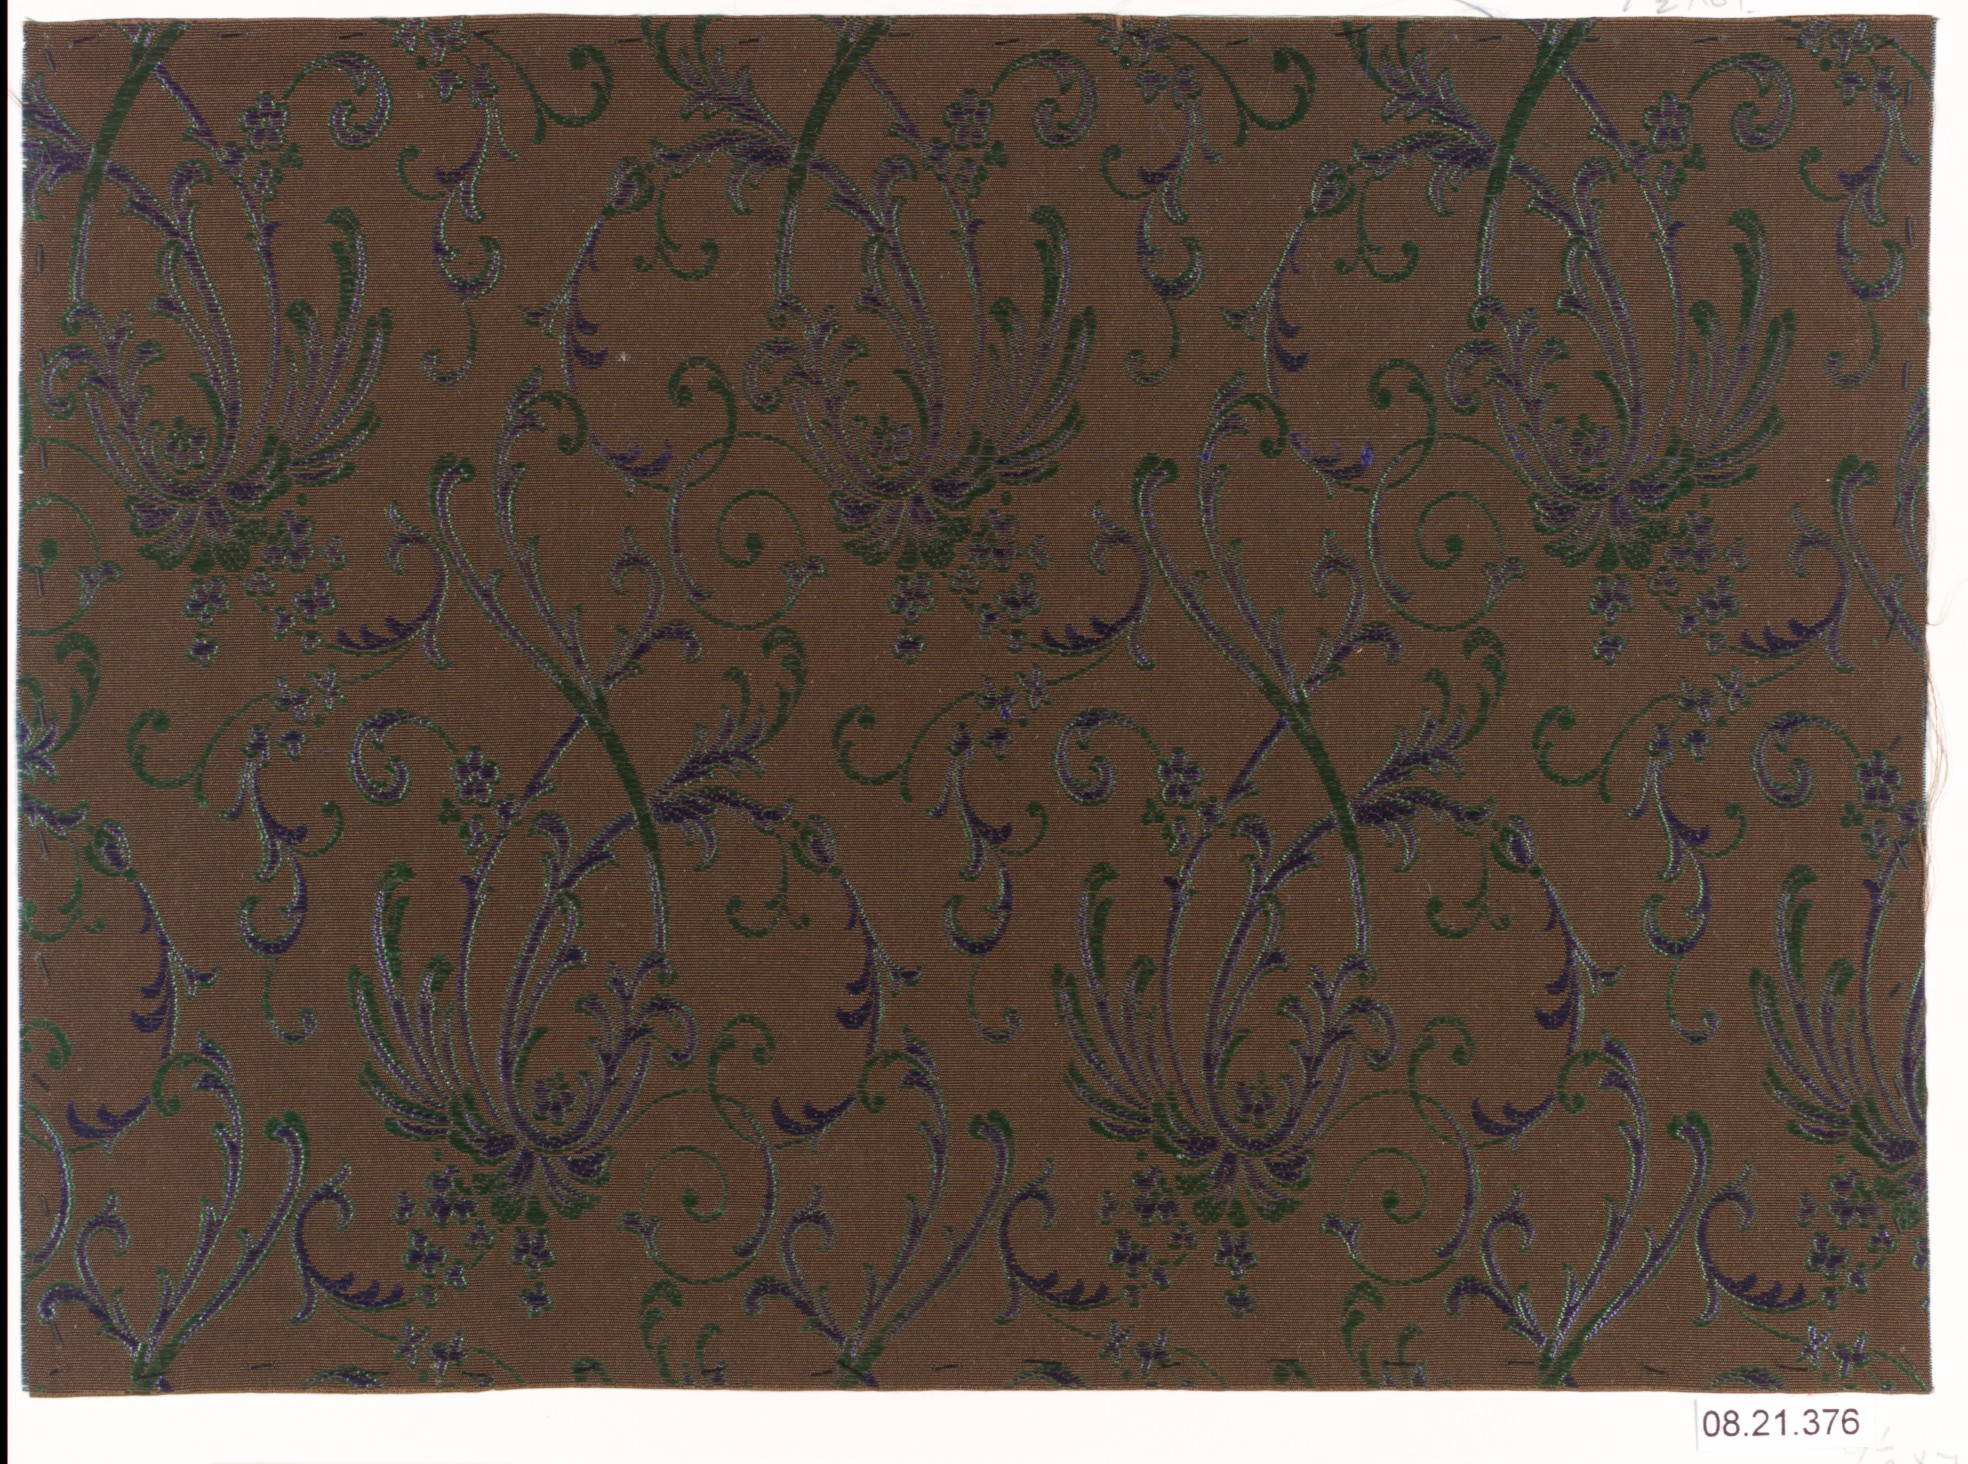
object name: textile sample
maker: Anonymous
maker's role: designer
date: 1900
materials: silk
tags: flowers